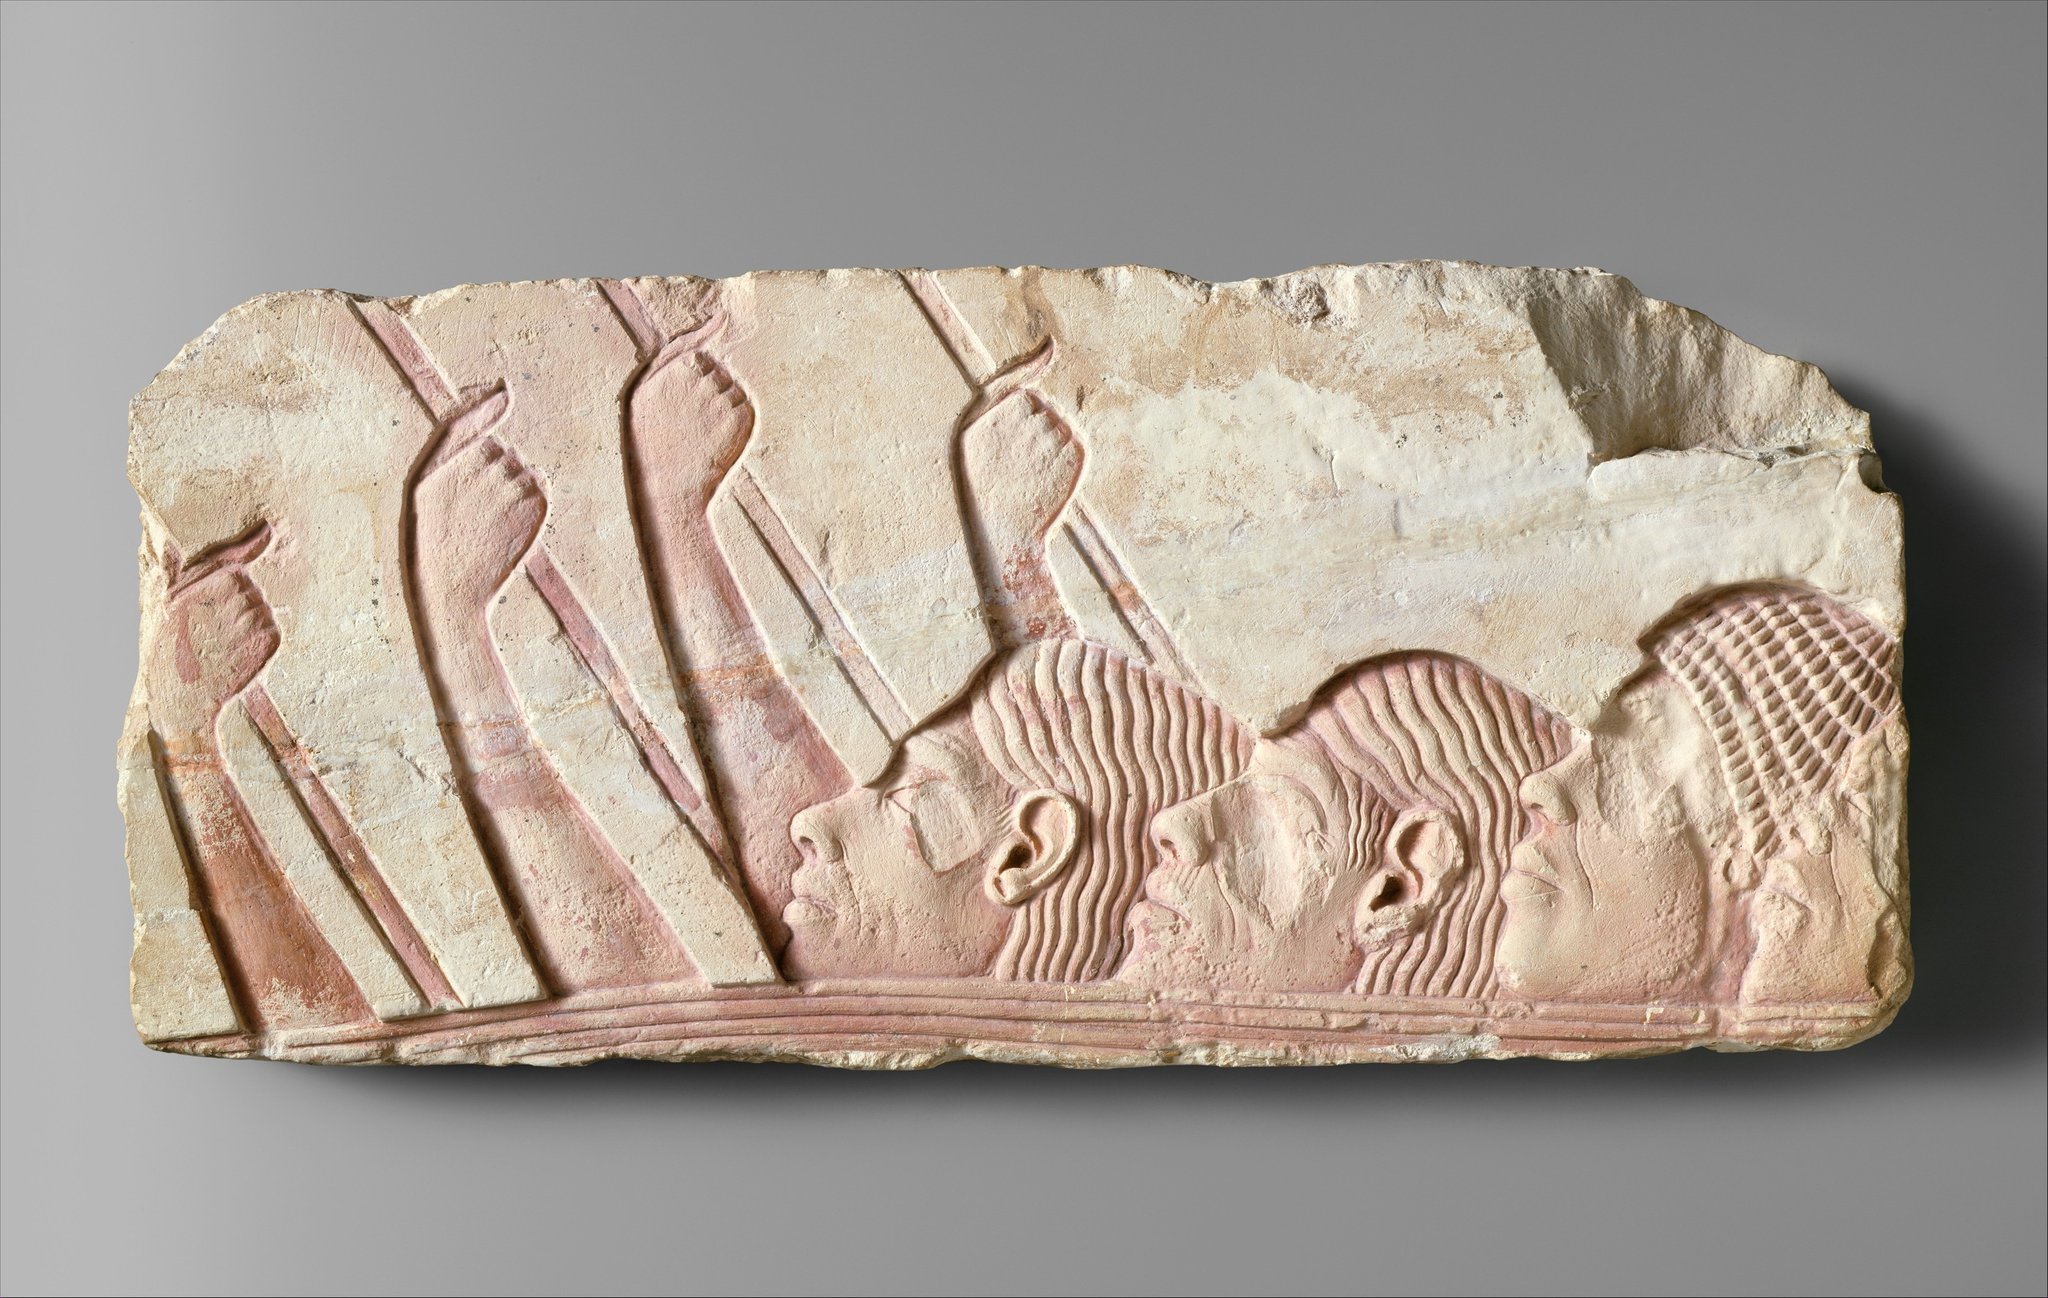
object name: talatat, attendant, foreigner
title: Attendants in a Procession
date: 1353-1336 BCE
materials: limestone, paint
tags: heads,processions